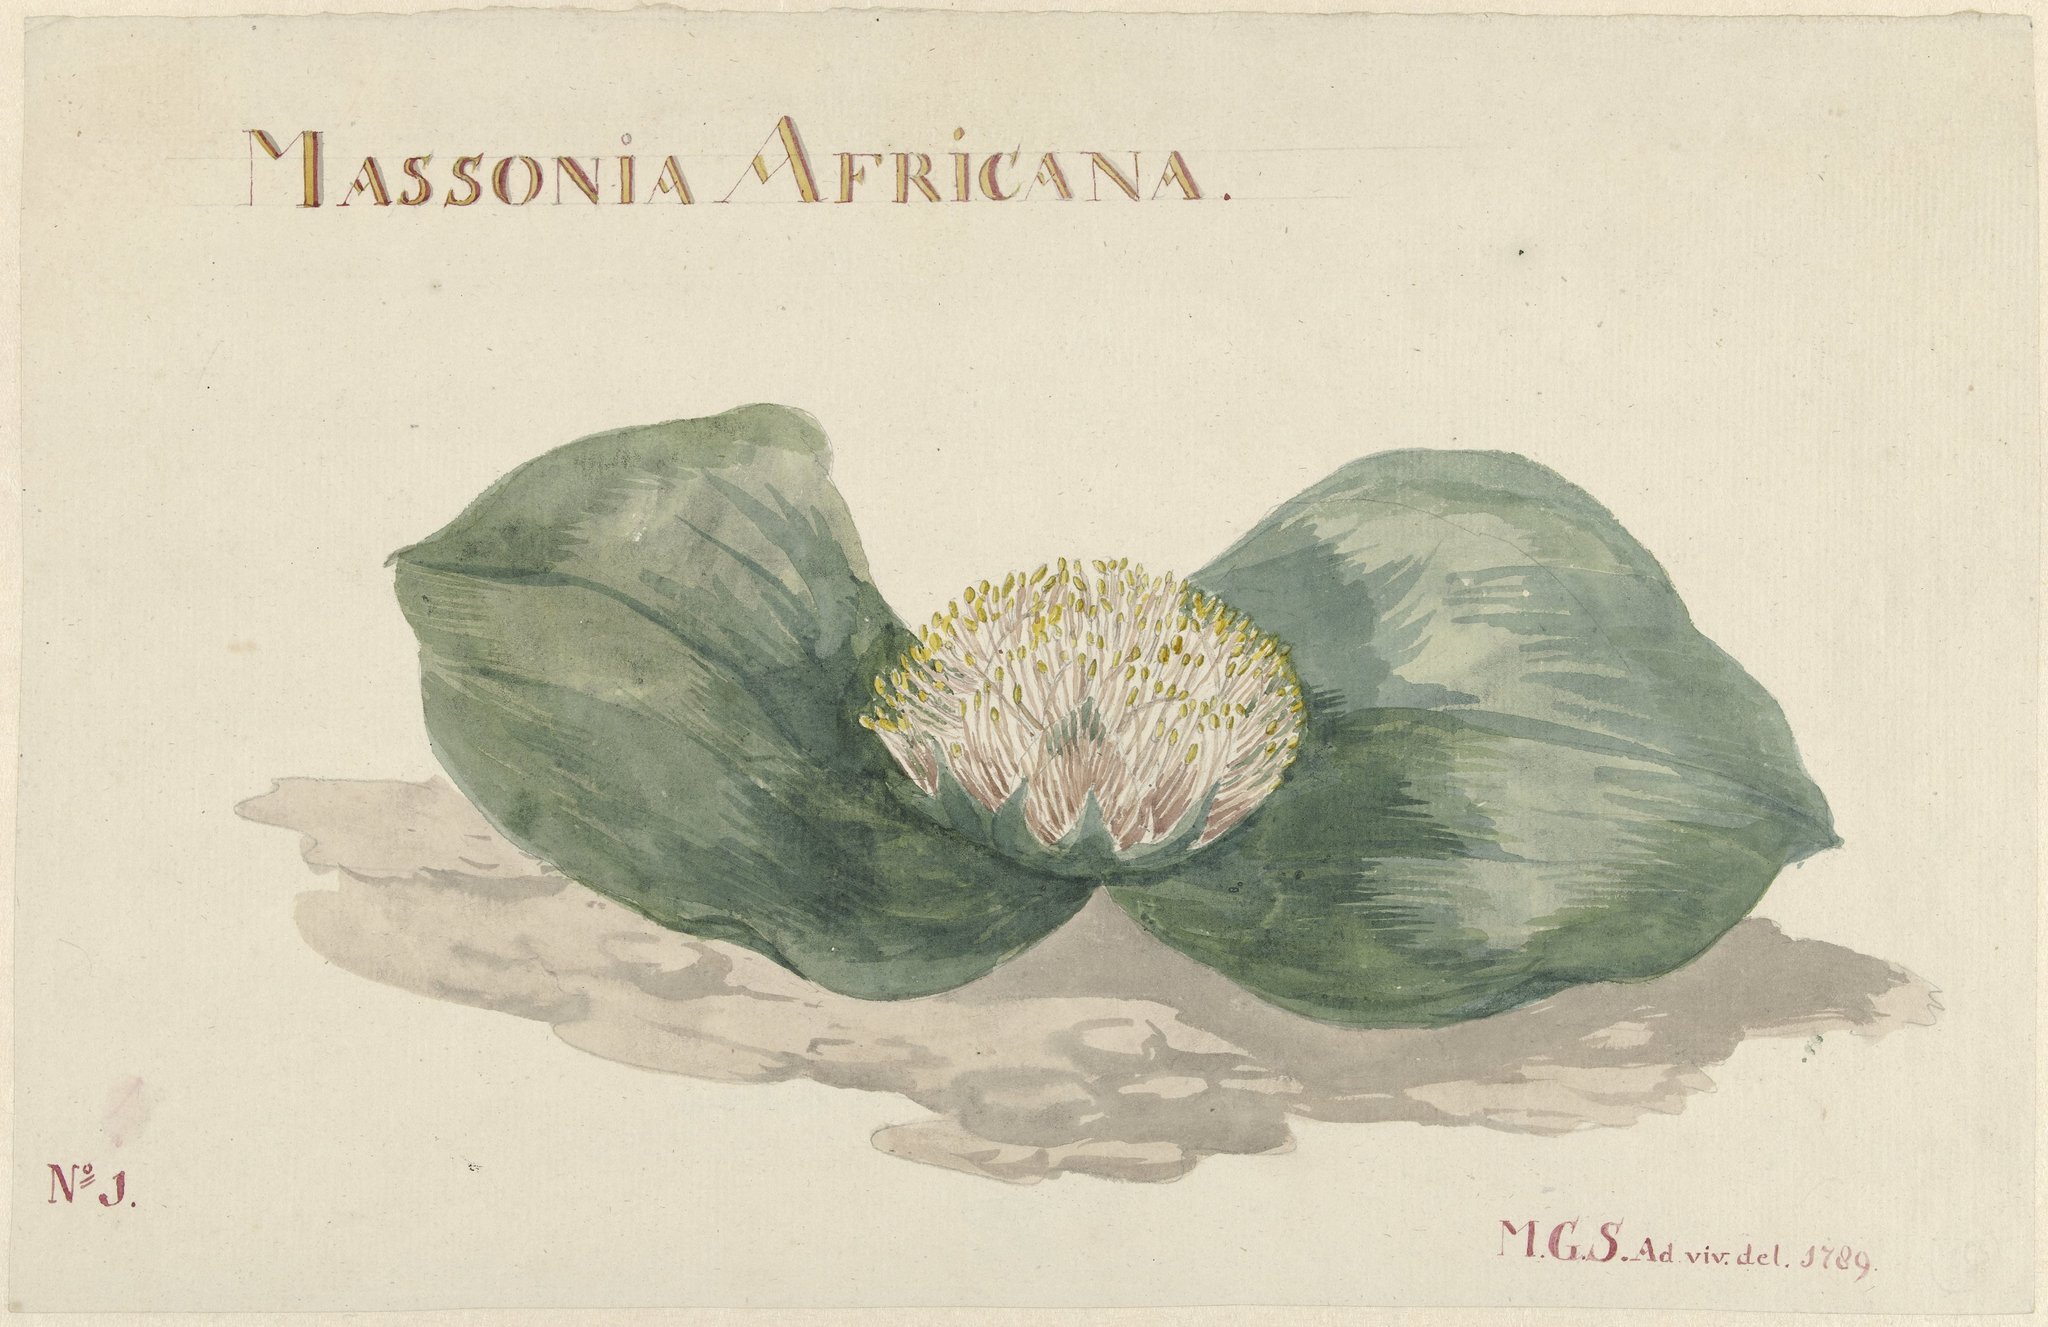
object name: watercolor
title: Bloem Massonia Africana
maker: maria geertruida barbiers-snabilié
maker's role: draughtsman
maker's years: 1776-1838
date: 1789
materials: paper, pencil, watercolor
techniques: brush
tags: flowers: massonia africana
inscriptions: date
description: Waterlelie-achtige bloem: Massonia Africana. Onder: No. 1.